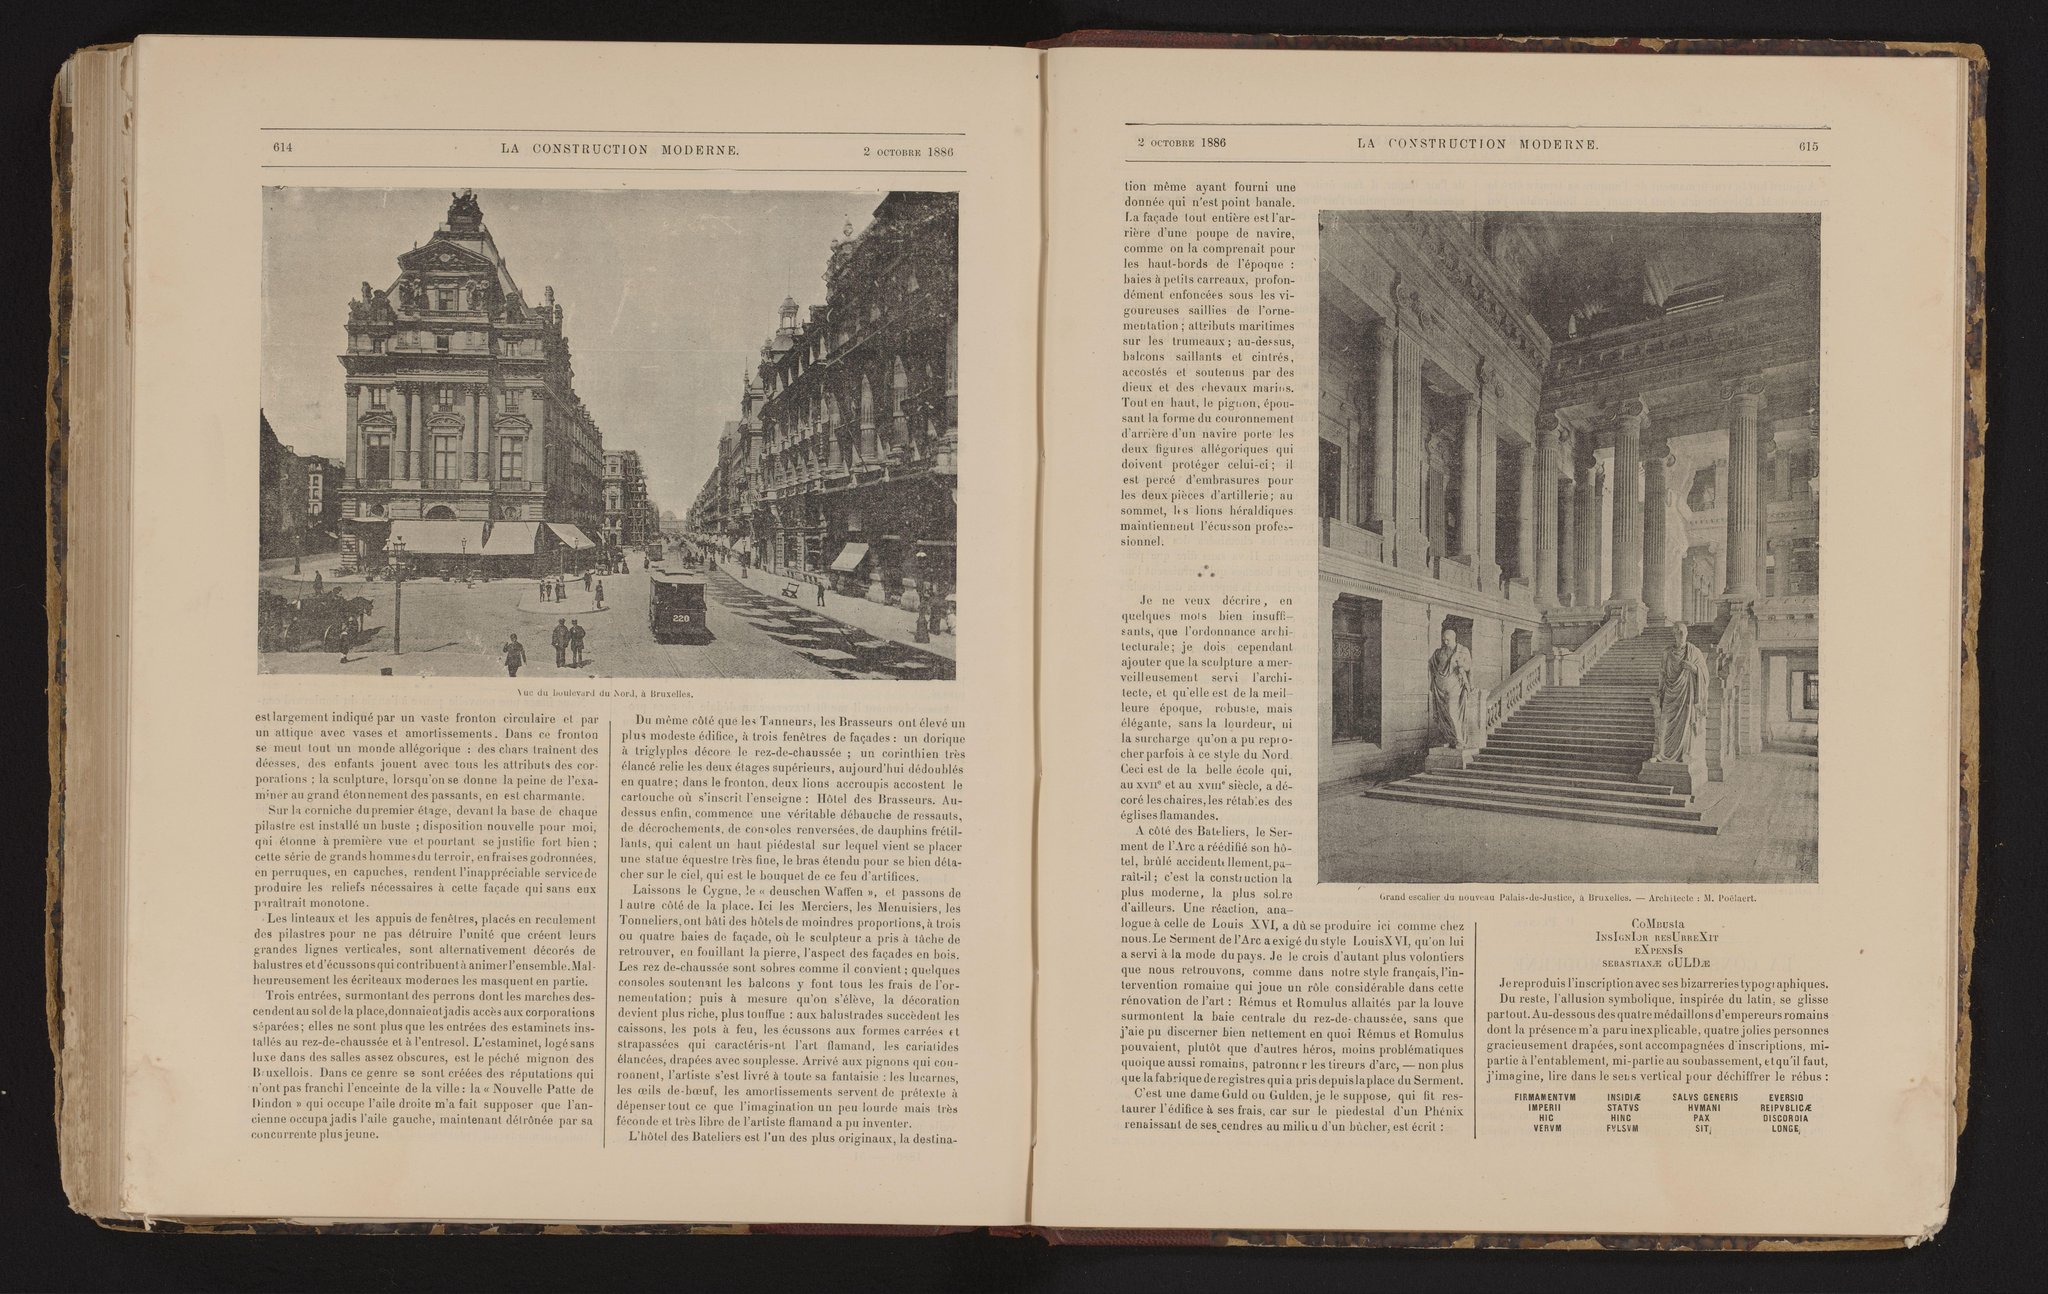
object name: page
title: Vue du boulevard du Nord, à Bruxelles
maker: Anonymous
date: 1881-1886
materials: paper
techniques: autotype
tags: avenue, boulevard, promenade, esplanade, brussels